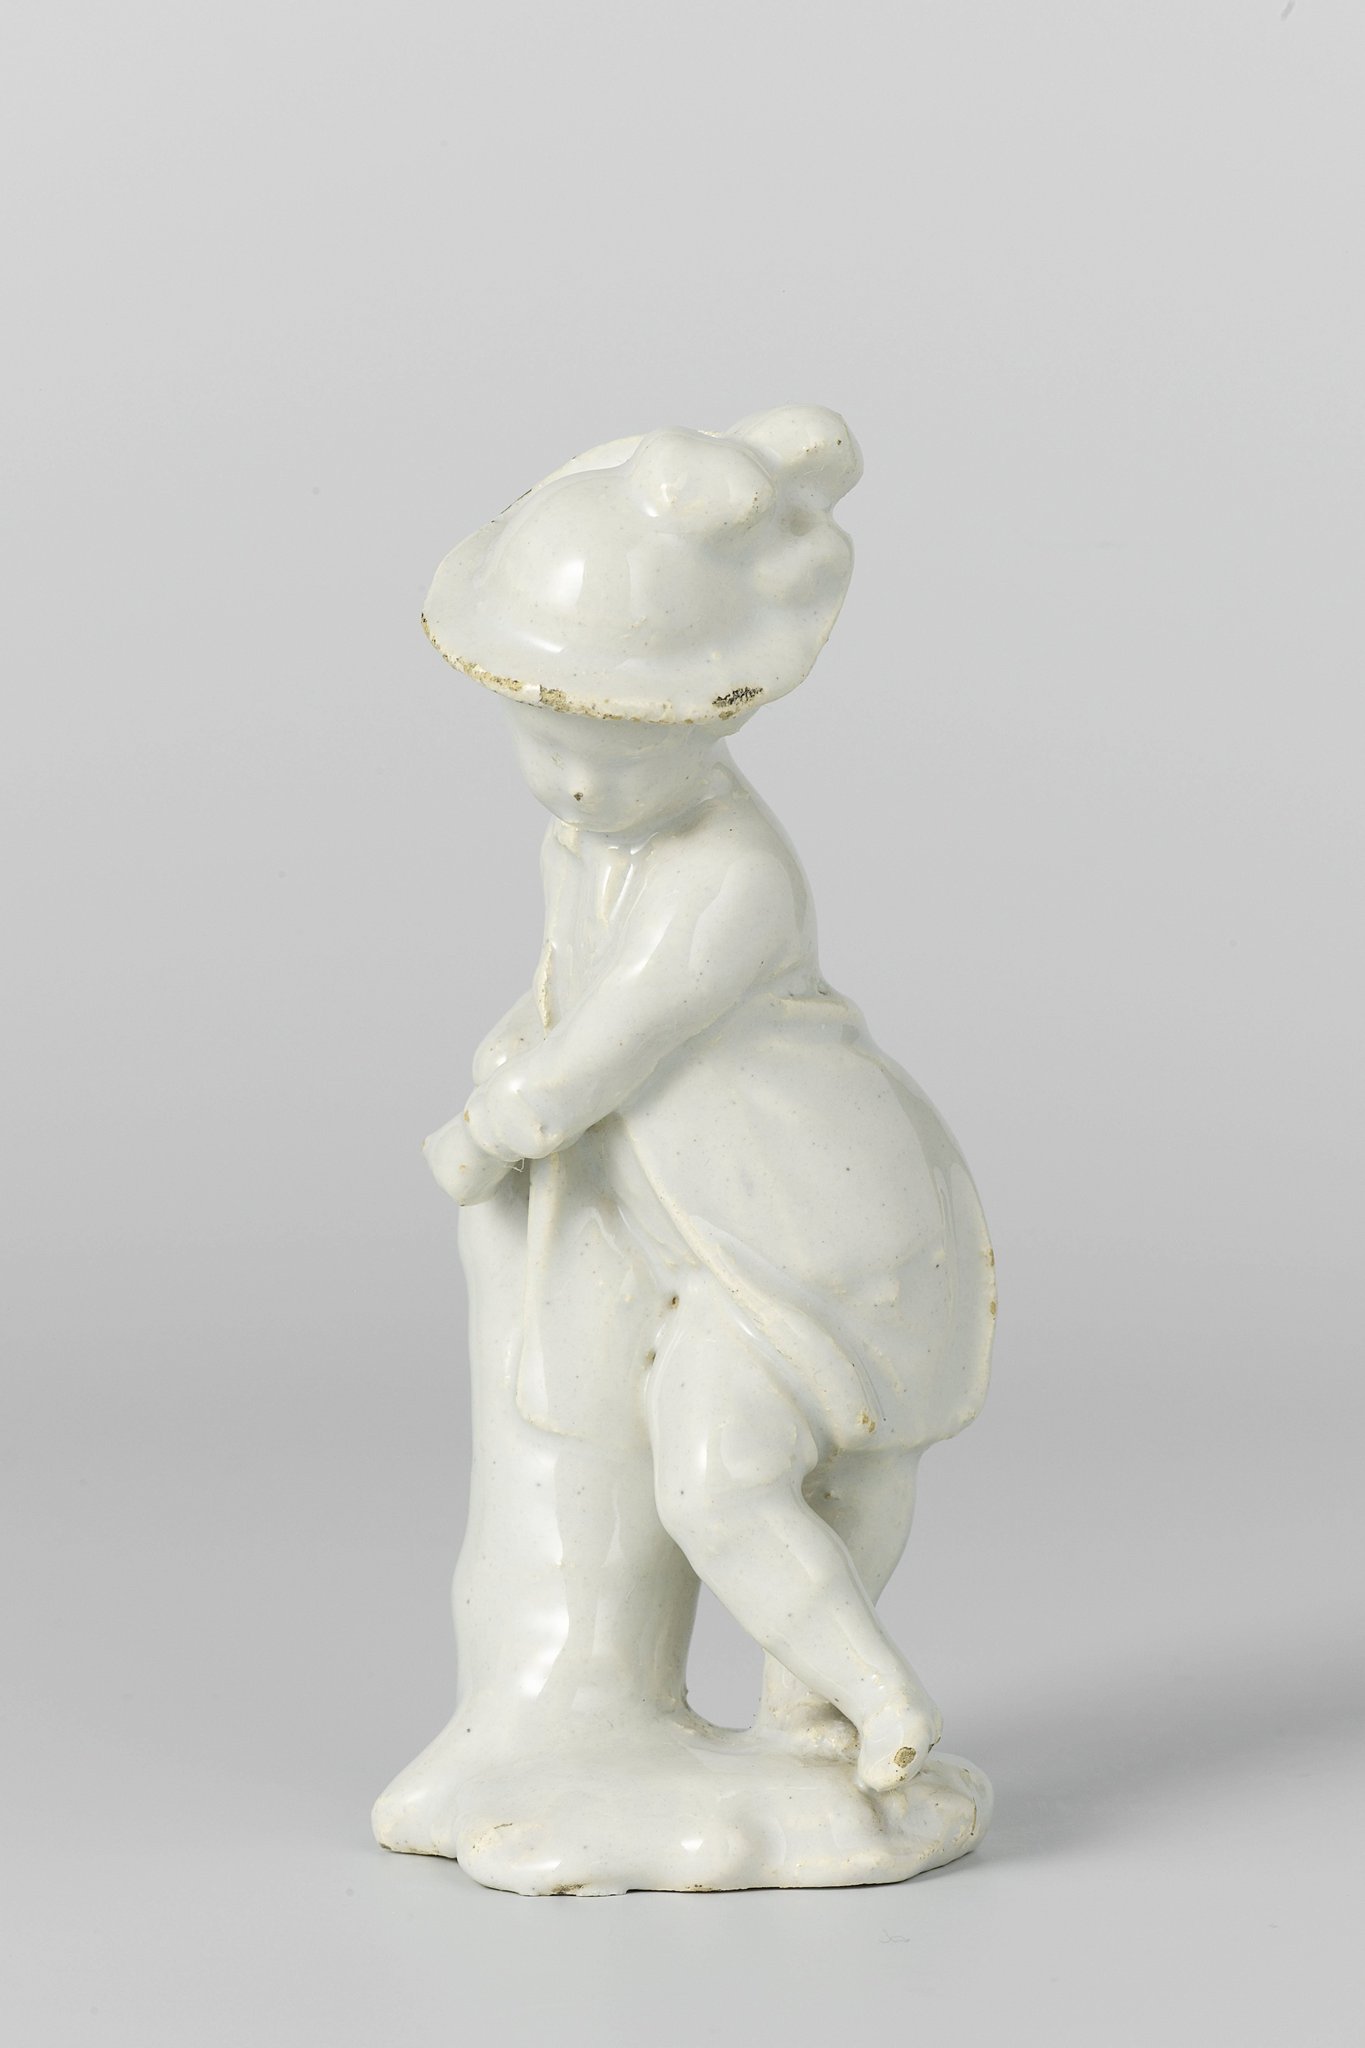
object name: decoratief object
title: Kinderfiguur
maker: Anonymous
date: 1755-1780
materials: faience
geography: delft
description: Kinderfiguur van faience, voorstellende een jongen geleund tegen een boomstronk. Wit geglazuurd.